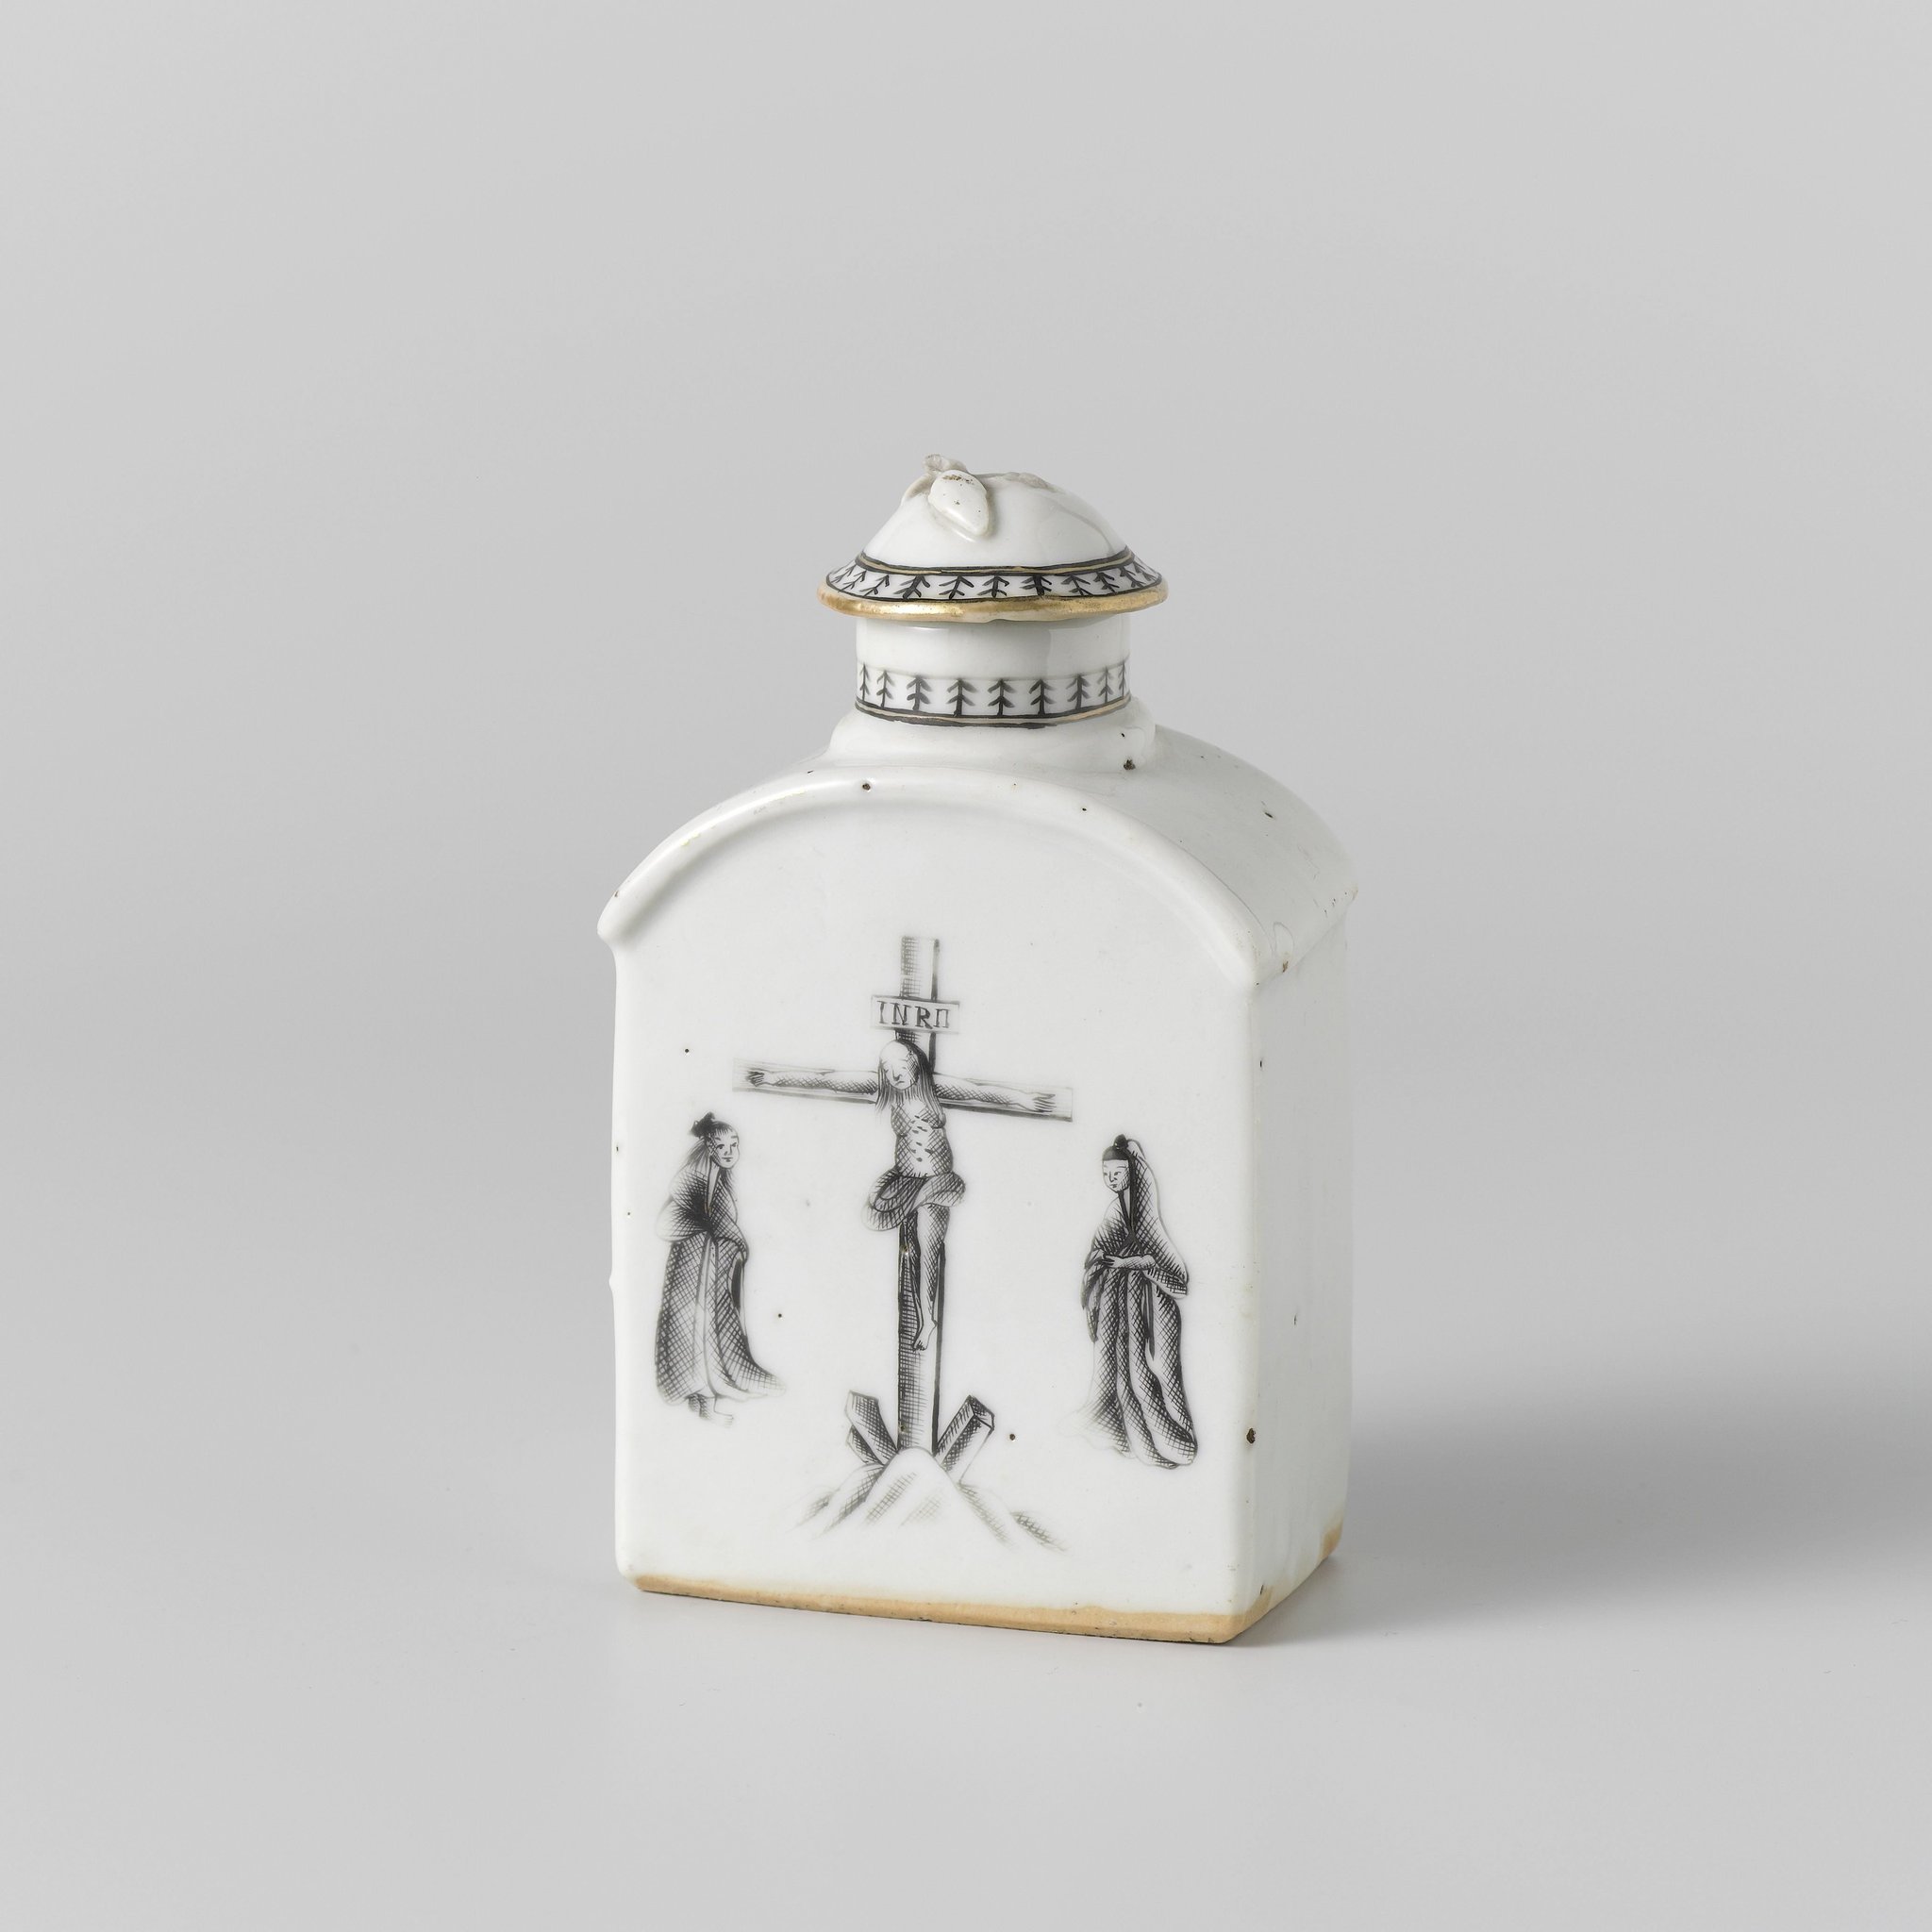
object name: tea caddy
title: Rectangular tea caddy with a crucifixion scene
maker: Anonymous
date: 1780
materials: glaze, gold, paint, porcelain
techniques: firing, forming, gilding, turning, vitrification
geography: china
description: Theebus met deksel, gedecoreerd in encre de Chine en goud met een voorstelling van de Kruisiging. Behorend tot theeservies.